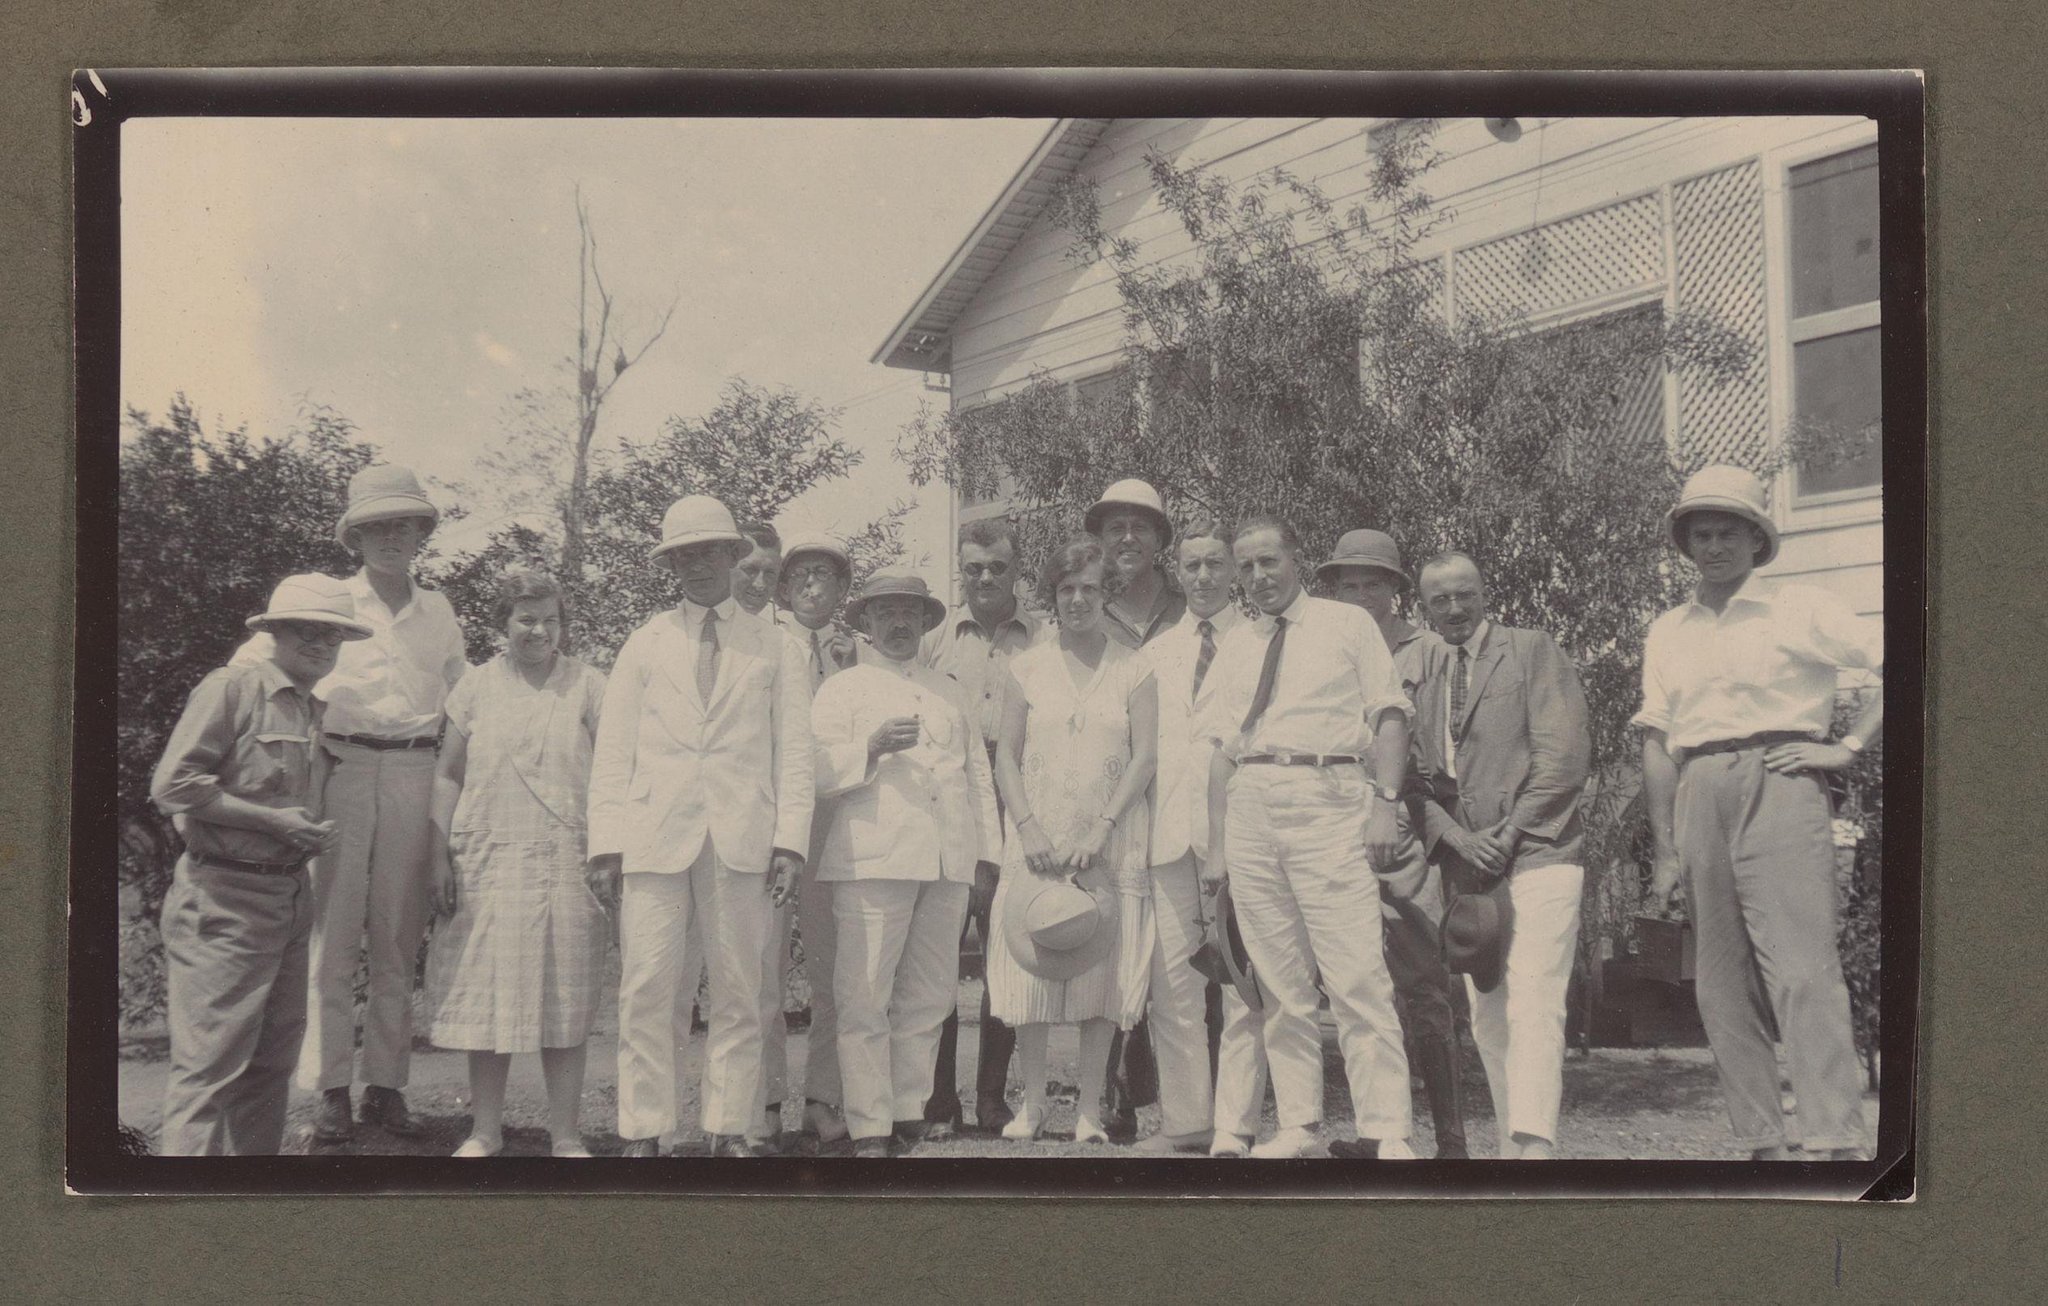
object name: photograph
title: Groepsfoto voor een huis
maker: Anonymous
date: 1925-1927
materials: photographic support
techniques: photography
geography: suriname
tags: jetten, familie, moengo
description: Groepsfoto voor een huis, waarschijnlijk te Moengo. Foto op een bladzijde van een los albumblad. Onderdeel van het ensemble met foto's van de familie van ingenieur Jetten in de mijnbouwstad Moengo in Suriname.